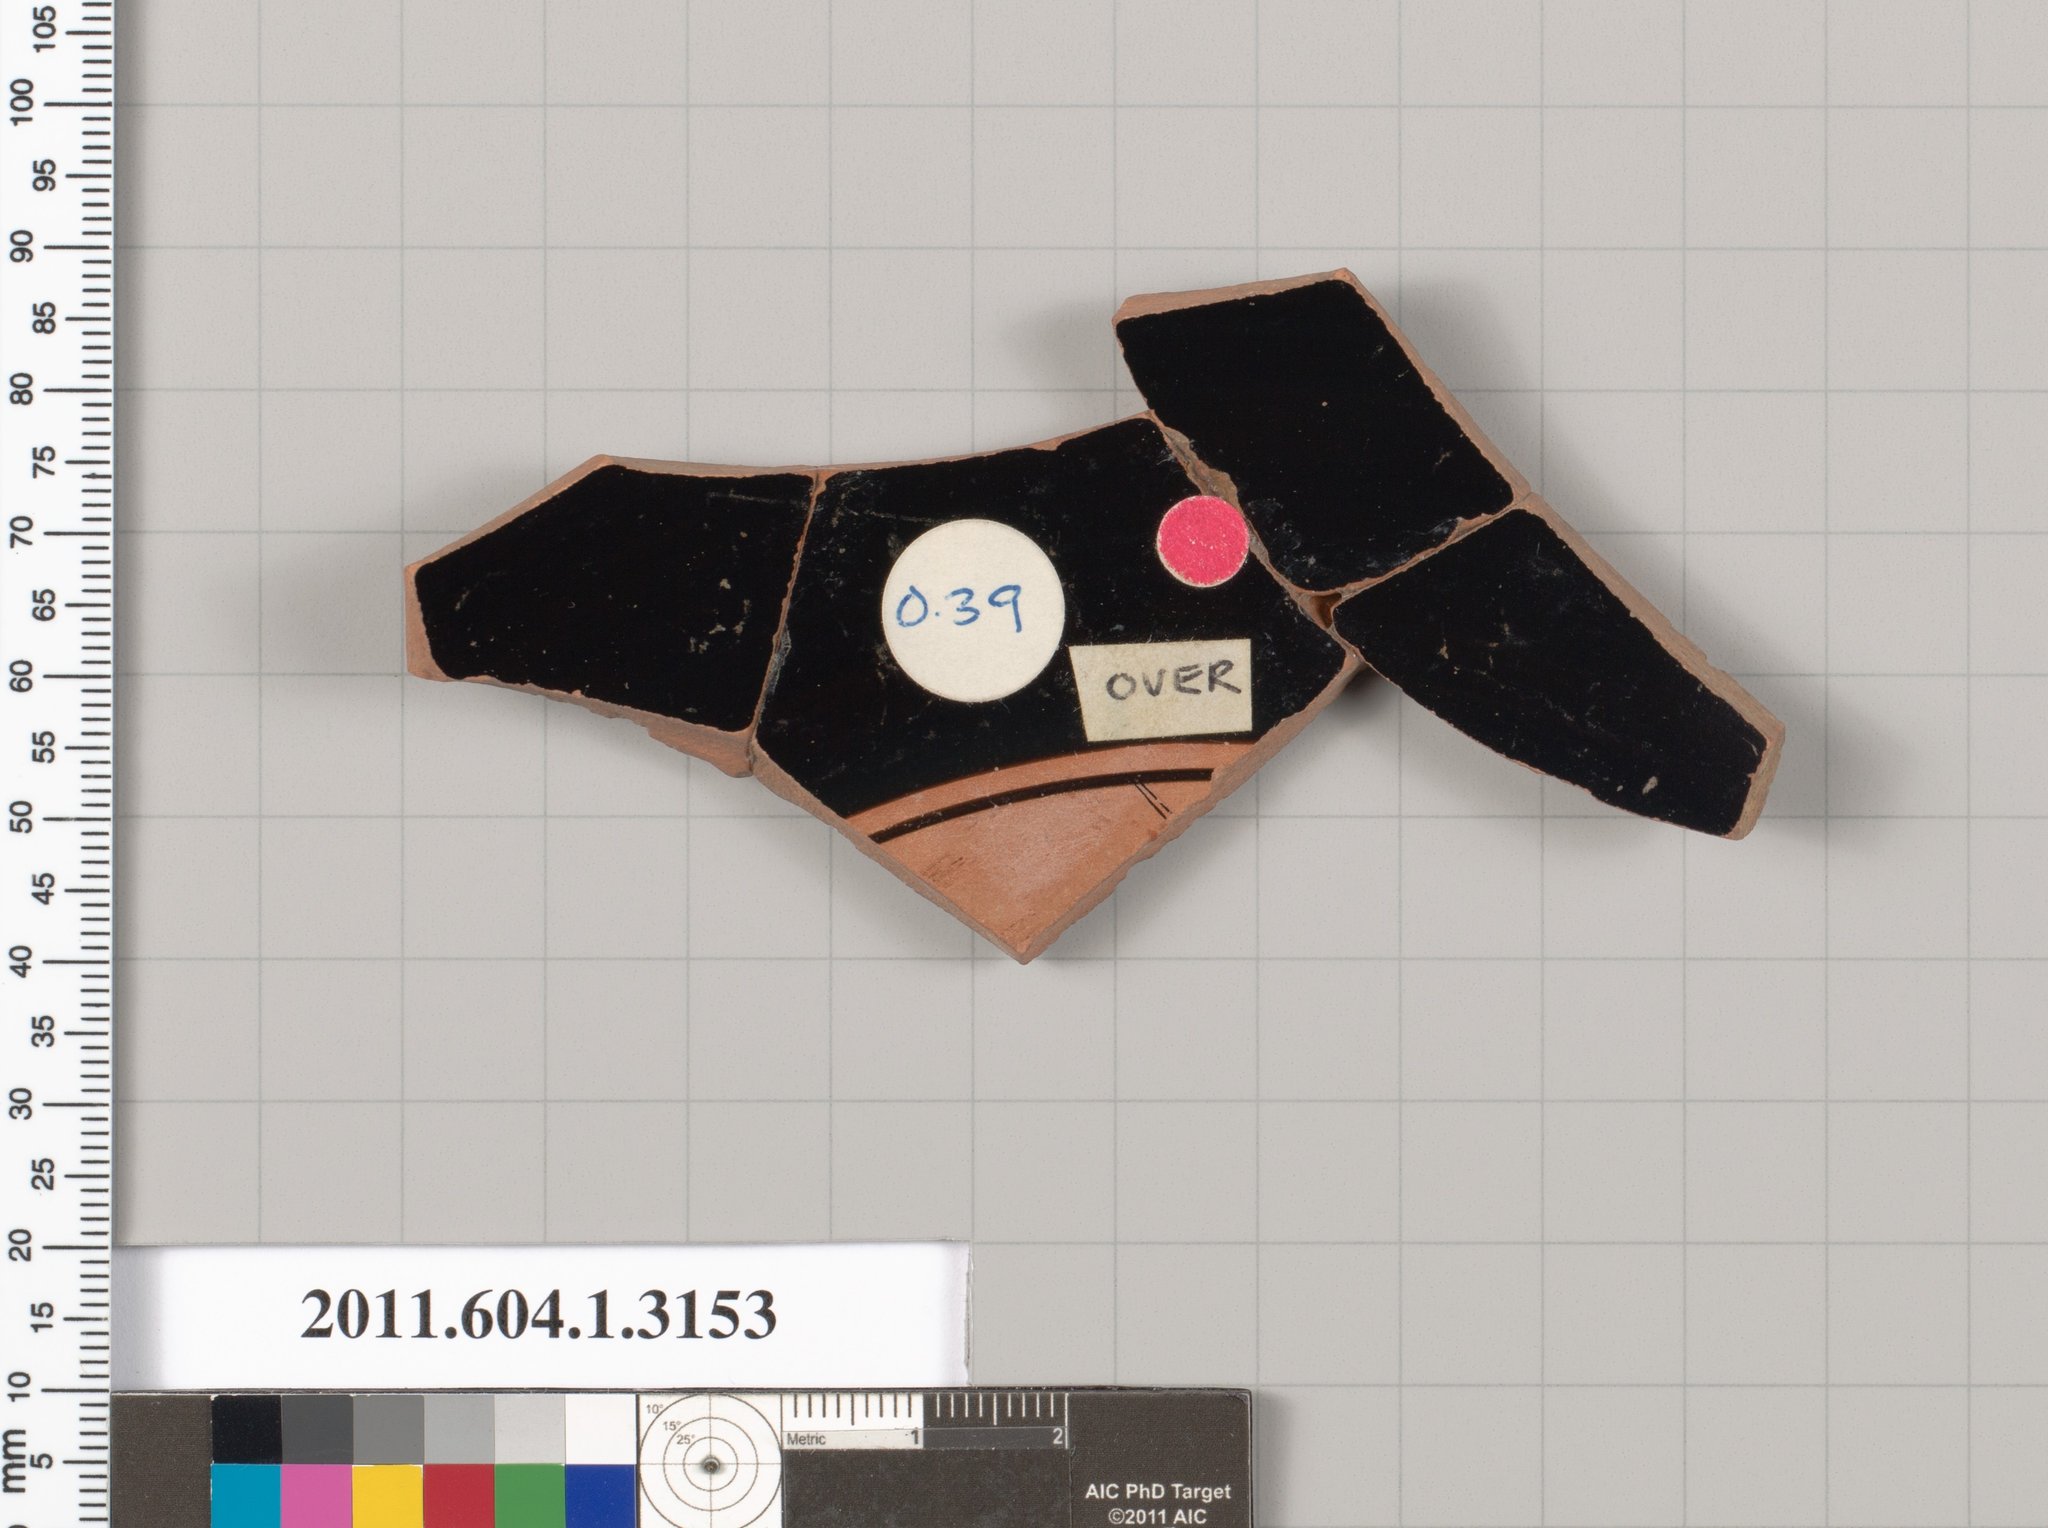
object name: kylix fragment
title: Terracotta fragment of a kylix (drinking cup)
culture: greek, attic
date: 500-490 BCE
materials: terracotta